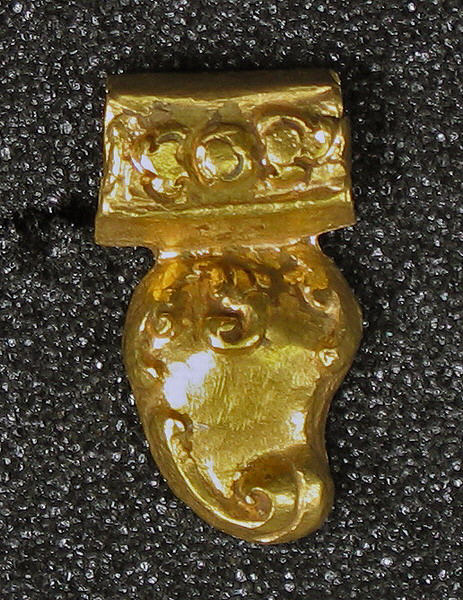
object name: necklace element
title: Pair of Tiger Claw Necklace Elements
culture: indonesian, central java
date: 701-1200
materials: gold